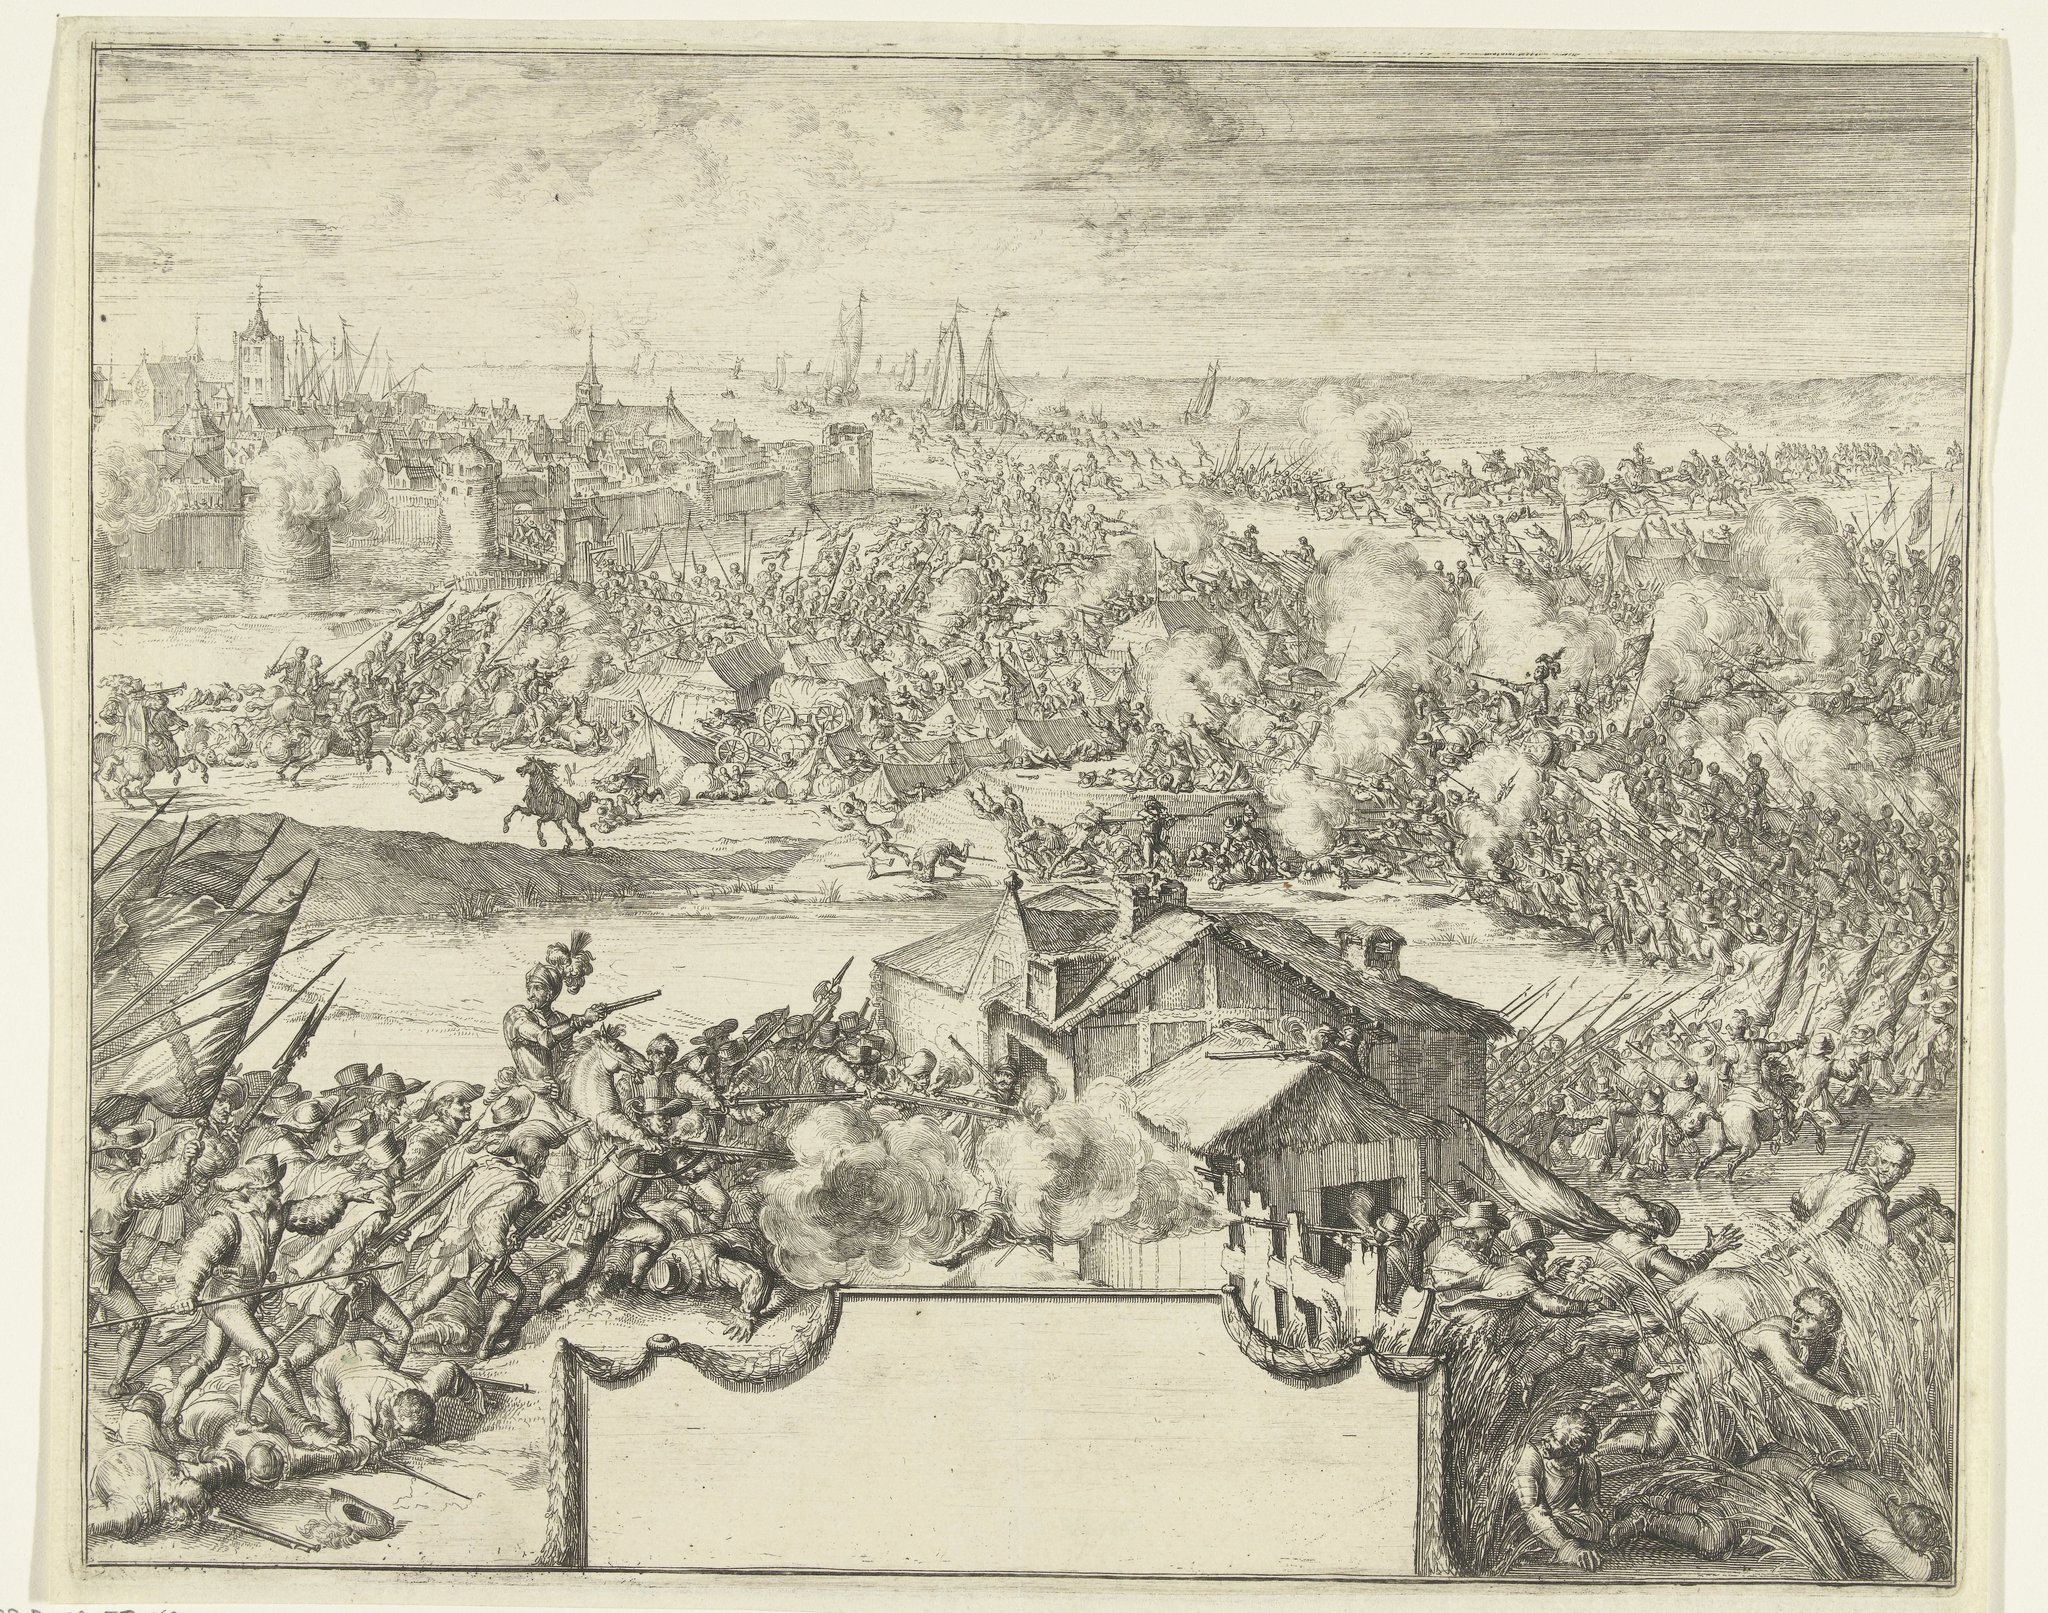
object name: history print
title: Slag bij Steenbergen, 1583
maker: romeyn de hooghe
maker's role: draughtsman, goldsmith, painter, print maker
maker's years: 1645-1708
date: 1670-1699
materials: paper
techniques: etching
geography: netherlands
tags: battle, fighting in general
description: Waarschijnlijk vervaardigd voor een uitgave van Histoire de la guerre de Flandre, van F. Strada, eind 17e eeuw. Staat vóór de letter.